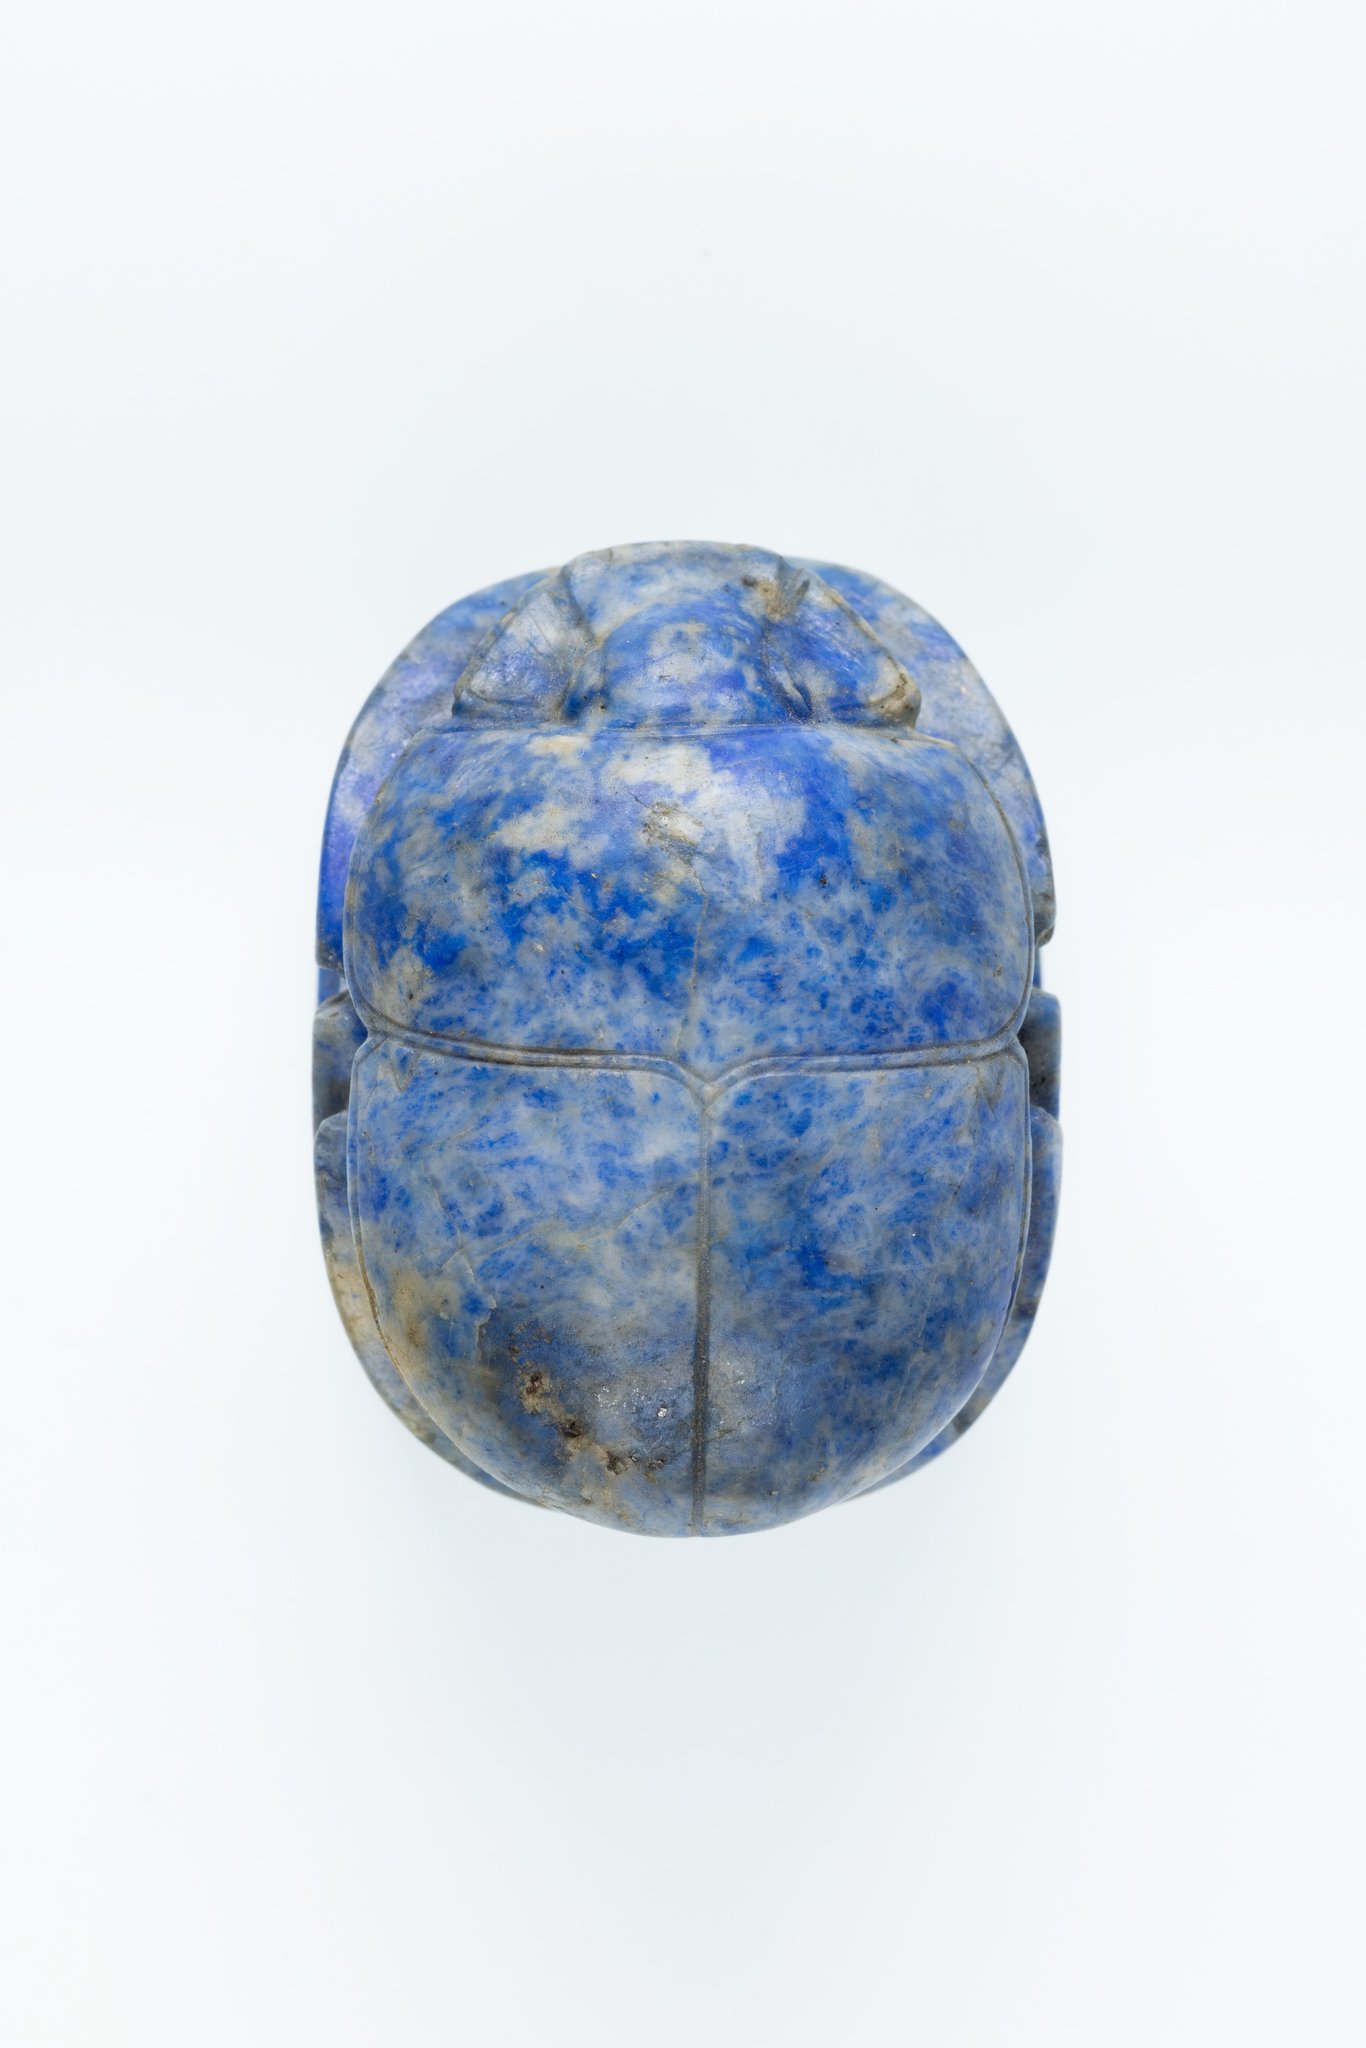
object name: scarab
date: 1070-343 BCE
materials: lapis lazuli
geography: egypt